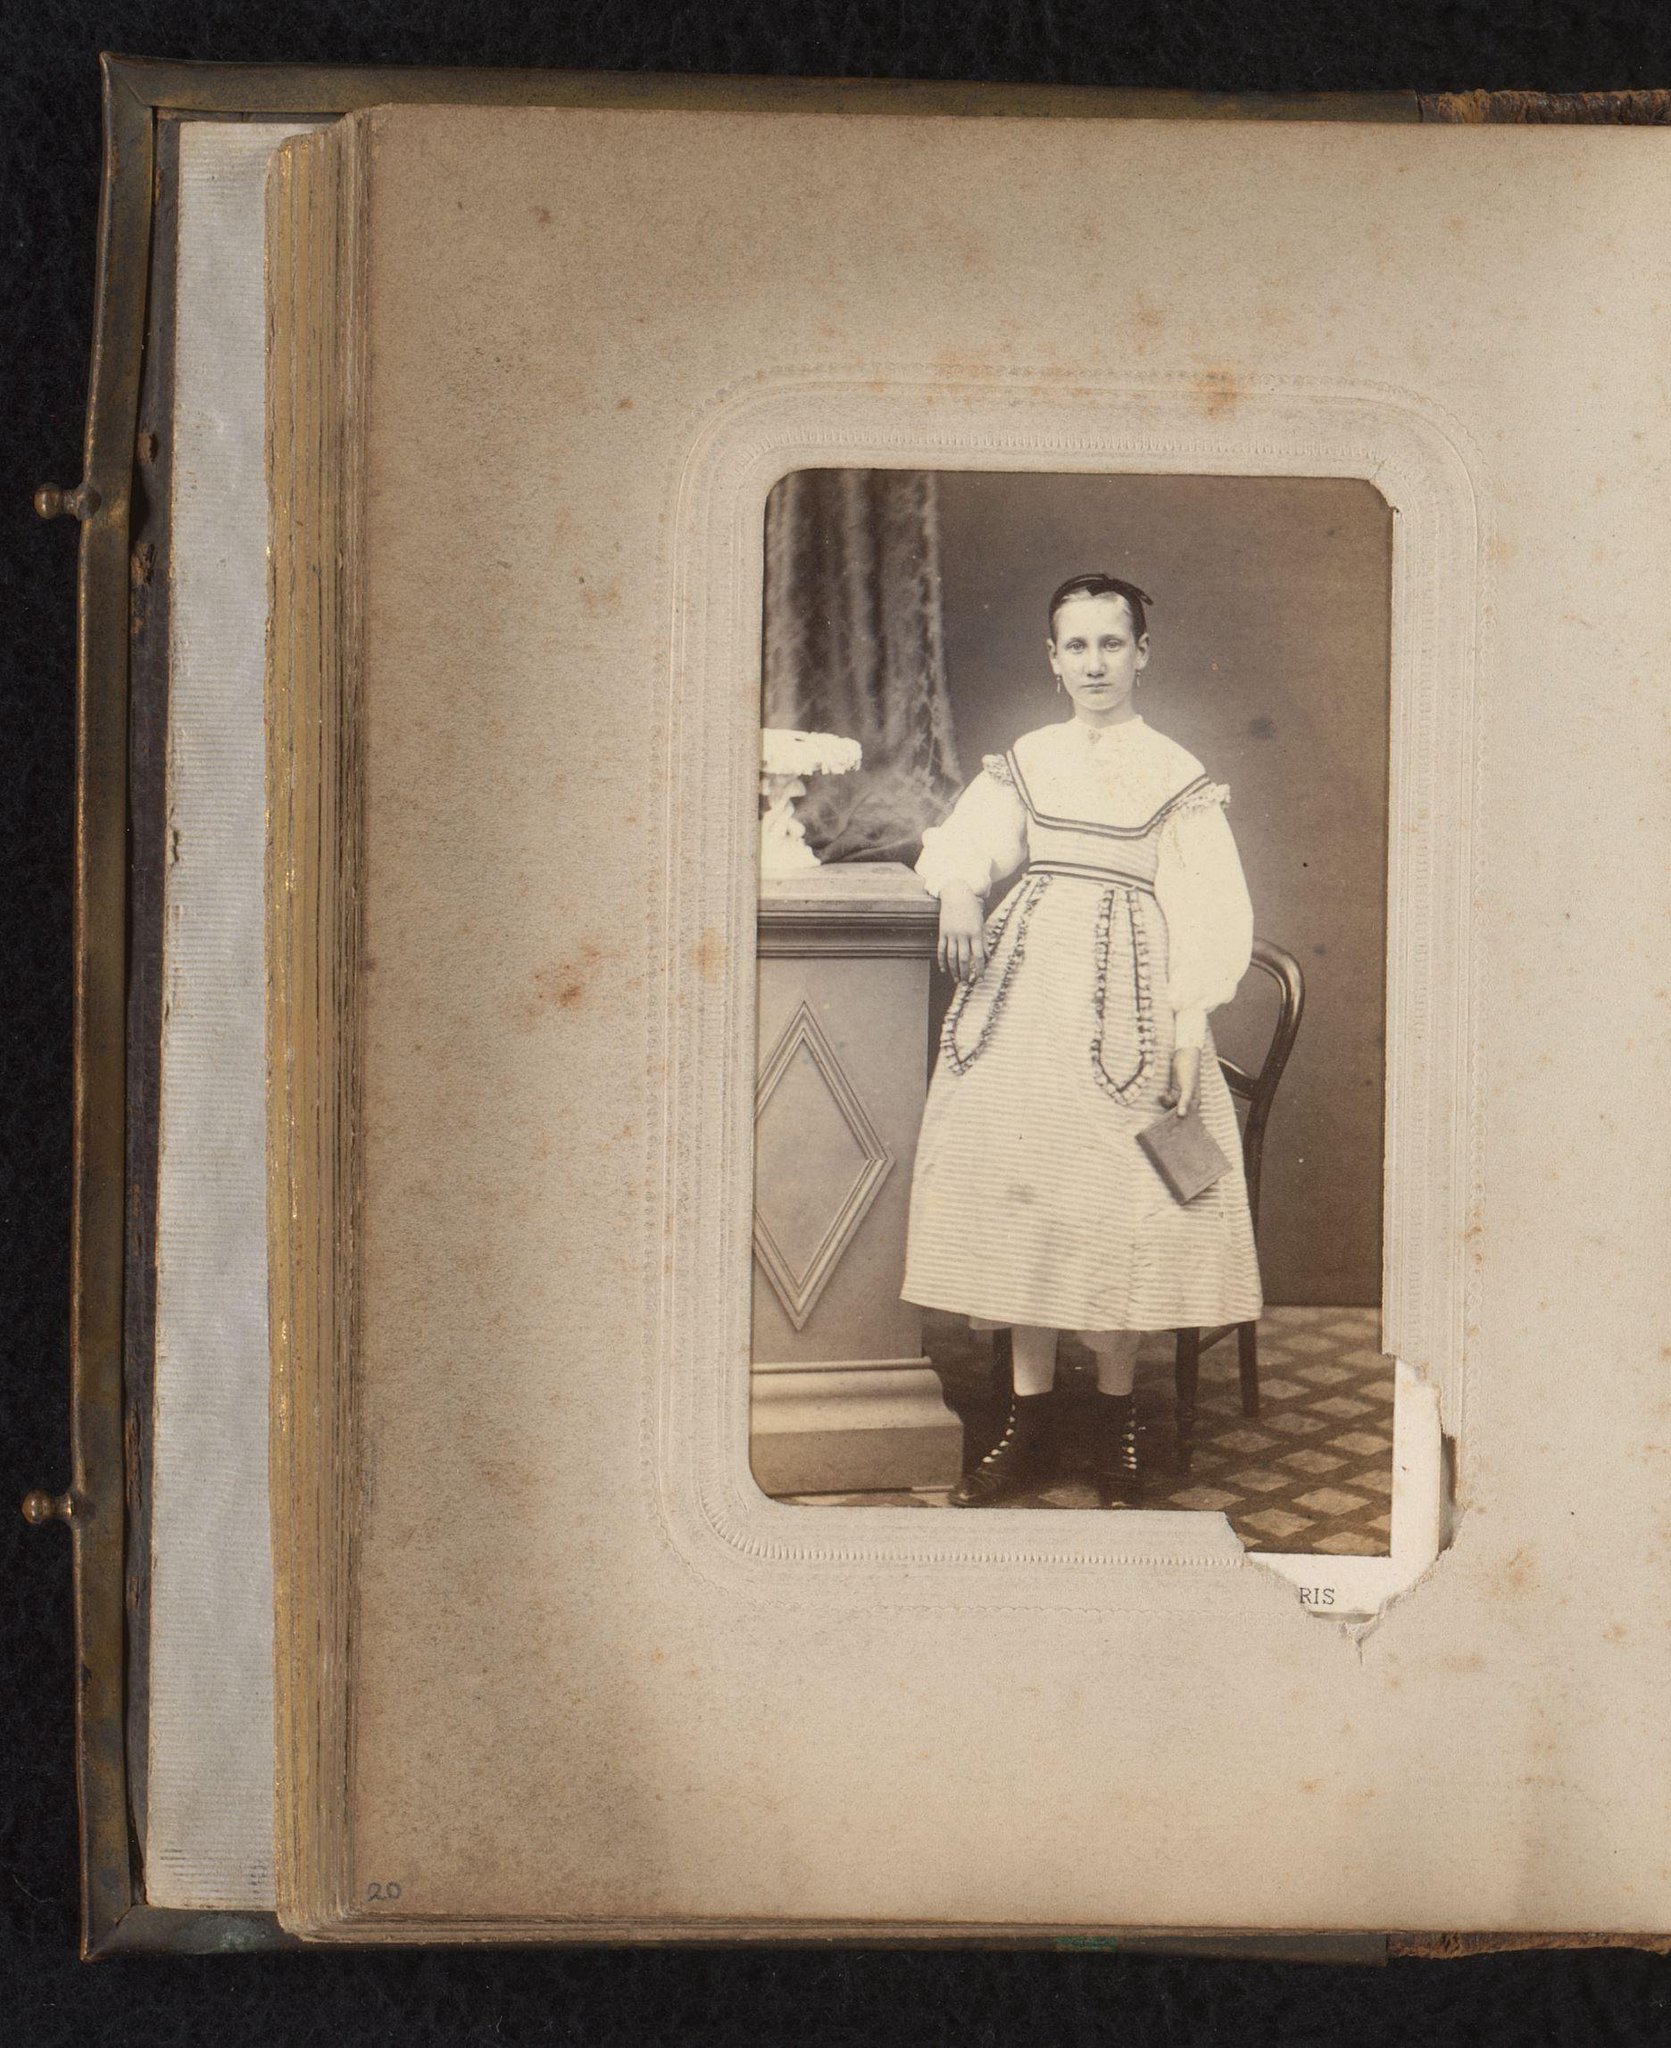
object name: photograph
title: Portret van een meisje met boek in de hand, staand bij een sokkel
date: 1860-1900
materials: cardboard, photographic support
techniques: albumen print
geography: elbeuf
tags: historical persons - bb - woman, girl (child between toddler and youth), book, pedestal of a piece of sculpture (perhaps in the form of a herm)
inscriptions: inscription: ‘PHOTOGRAPHIE/ A. DELAMARE & A. RAGUET/ 7, Rue de Paris, 7/ ELBEUF/ Tous les Clichés sont conservés’